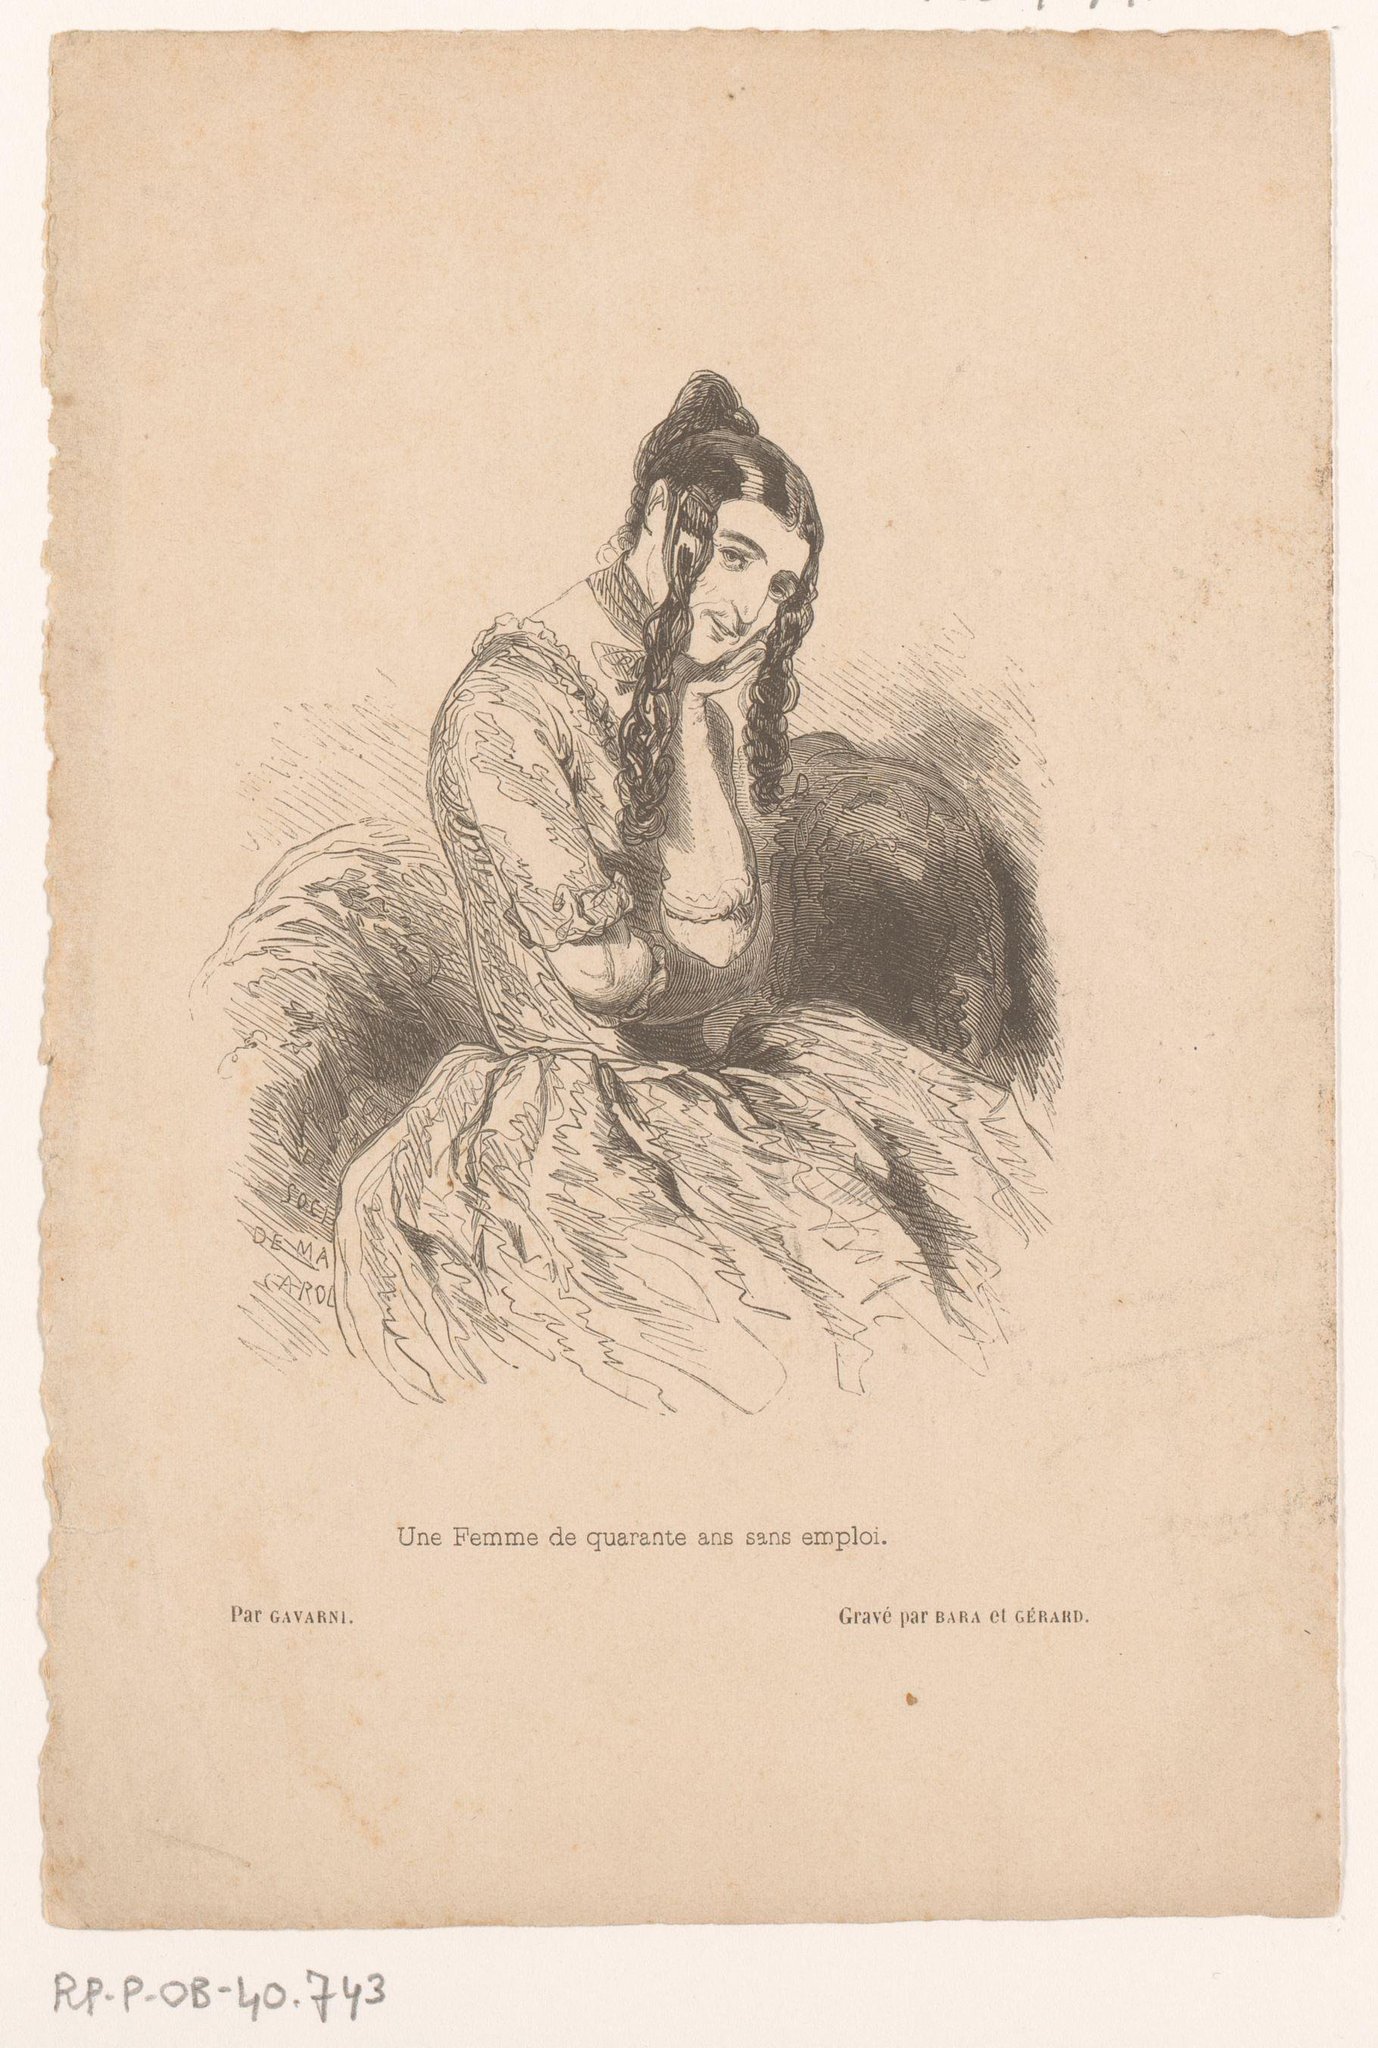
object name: print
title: Une Femme de quarante ans sans emploi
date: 1840-1842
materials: paper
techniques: lithograph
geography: paris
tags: sitting figure - aa - female human figure, unemployment - aa - women, various human types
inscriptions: collector's mark: Lugt 2228a